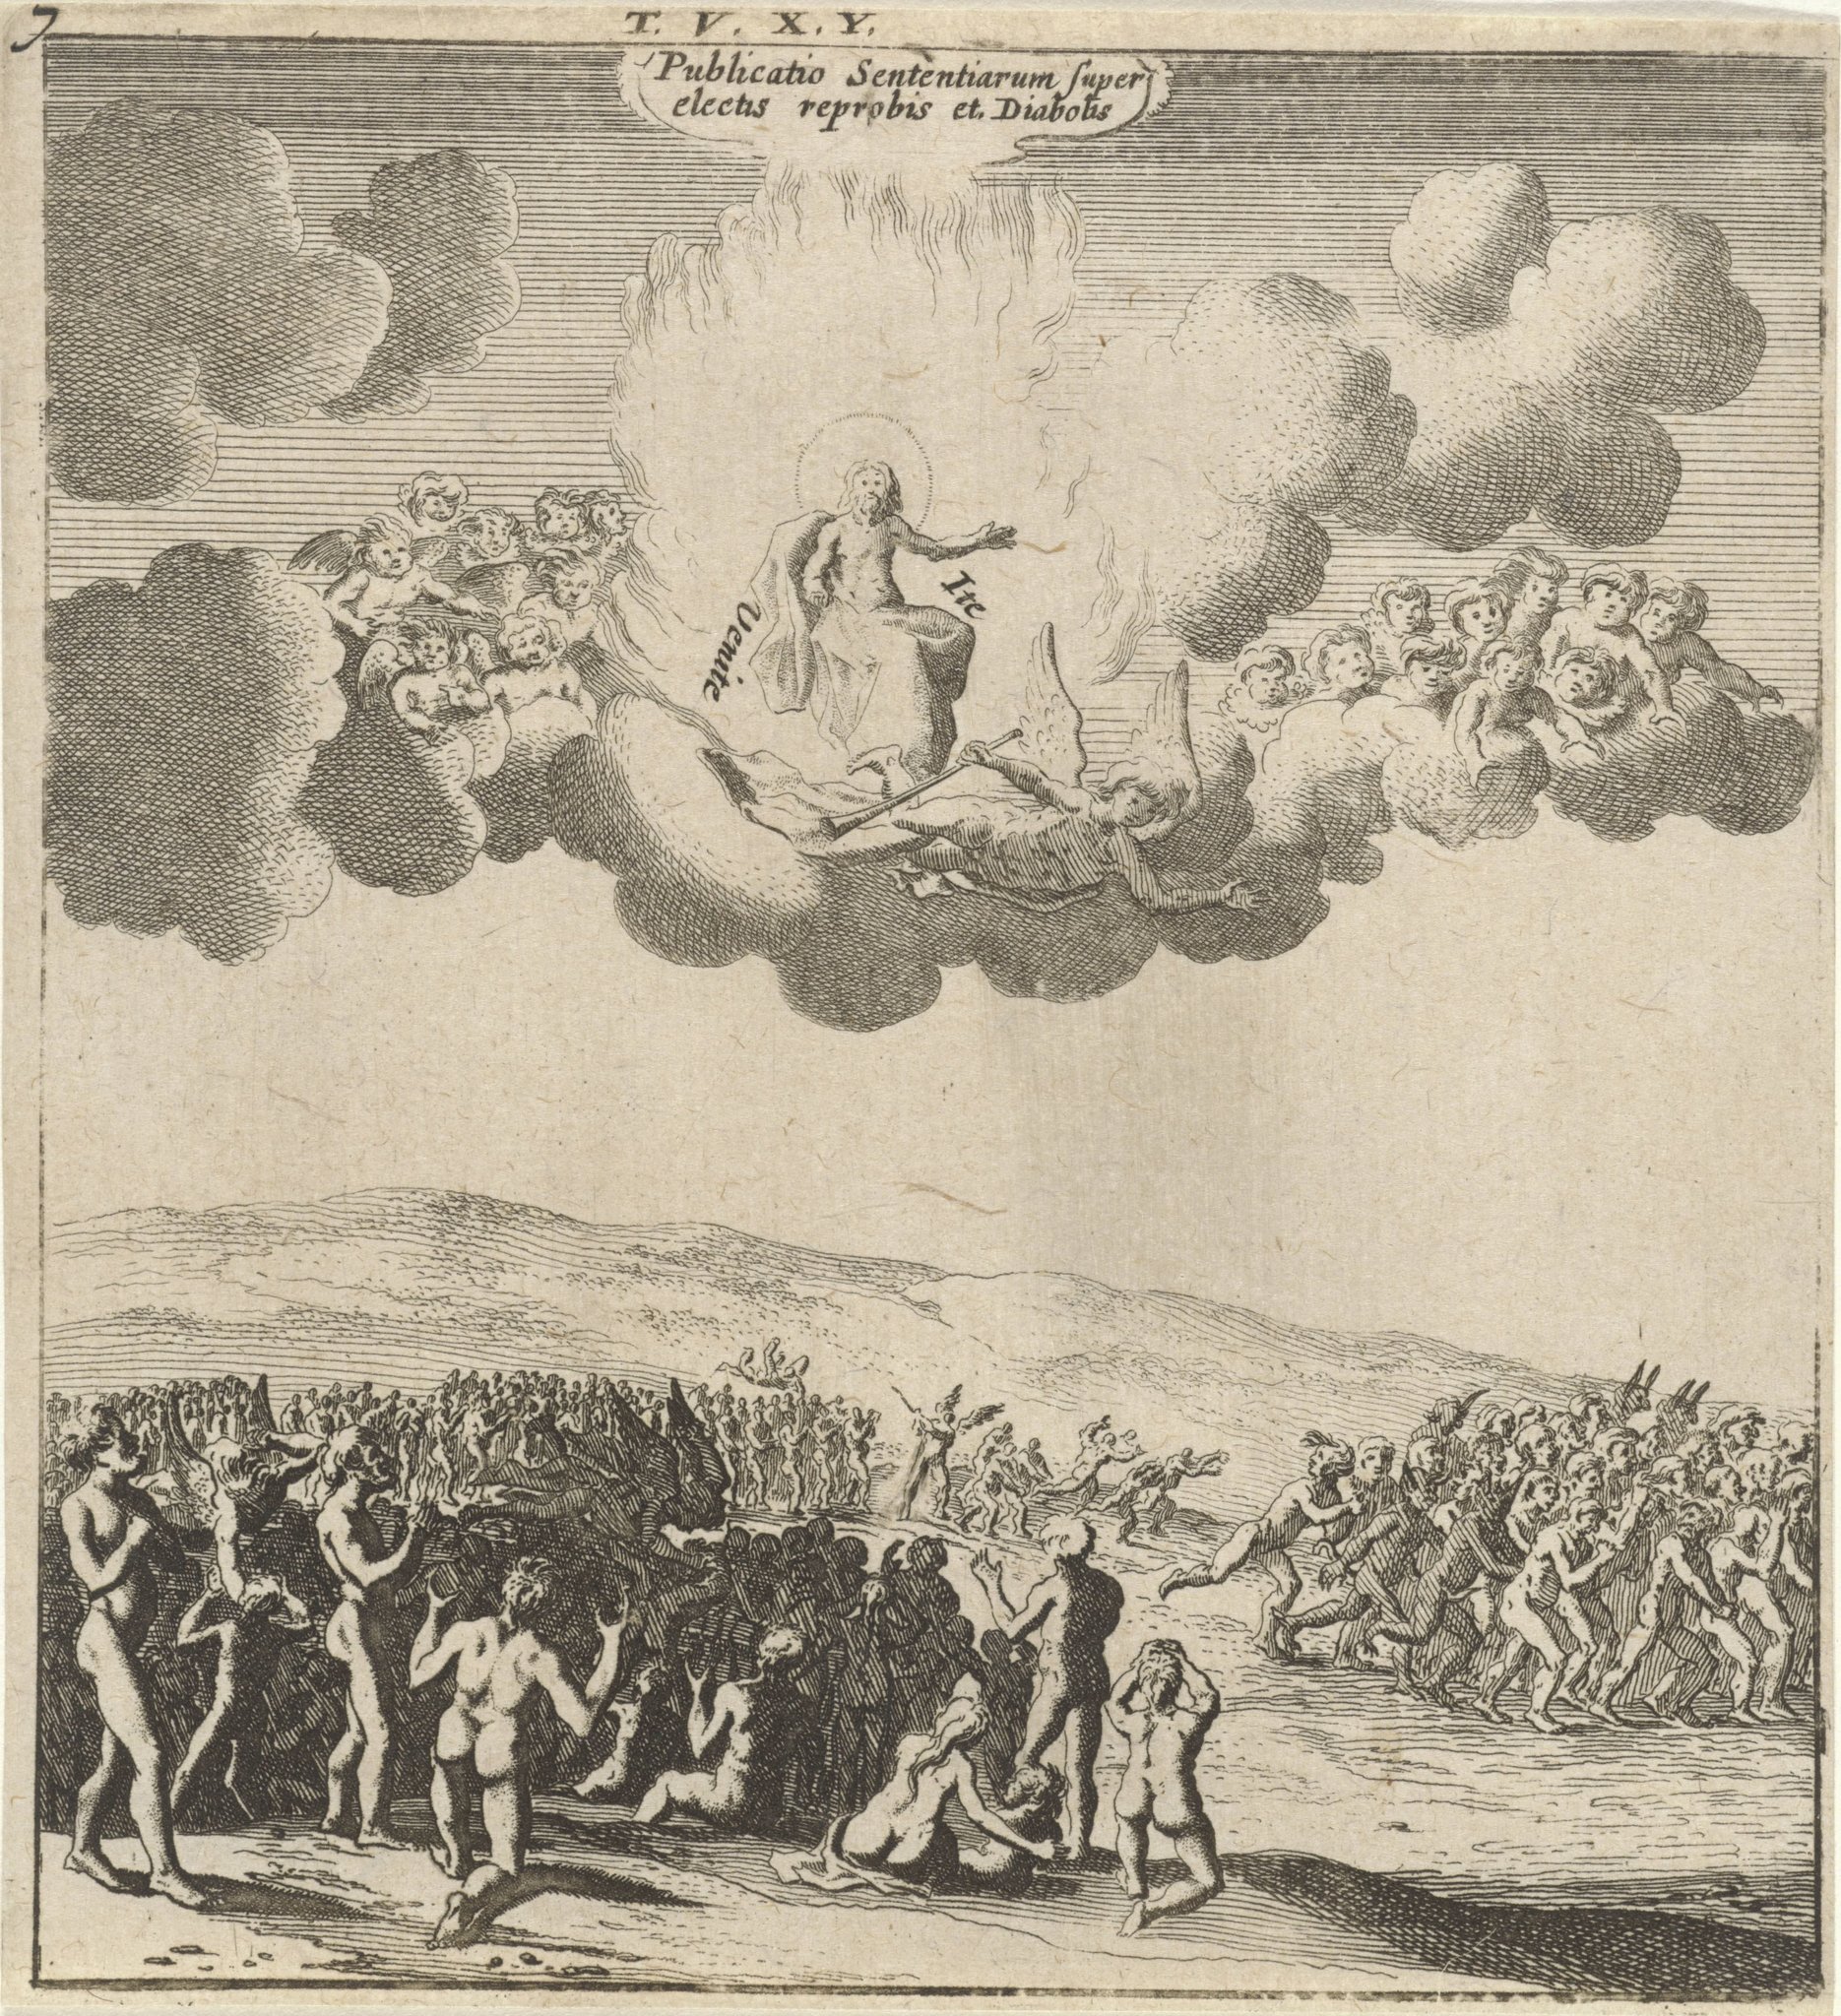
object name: print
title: Laatste Oordeel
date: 1625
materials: paper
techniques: etching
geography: haarlem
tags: comprehensive representation of last judgement: christ (with sword and lily), often surrounded by elders and sometimes accompanied by mary and john the baptist, appears in the sky with trumpeting angels (and sometimes angels holding the instruments of the passion); after the resurrection of the dead the blessed are led to heaven by angels, and the damned are dragged into hell by devils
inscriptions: collector's mark: Lugt 2228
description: Illustratie in: Peil, Johann. Tabula processum seu ordinem ultimi divini et criminalis judicii exhibens. Kleef: Gerhardus Verstegen, 1625, p. 48.